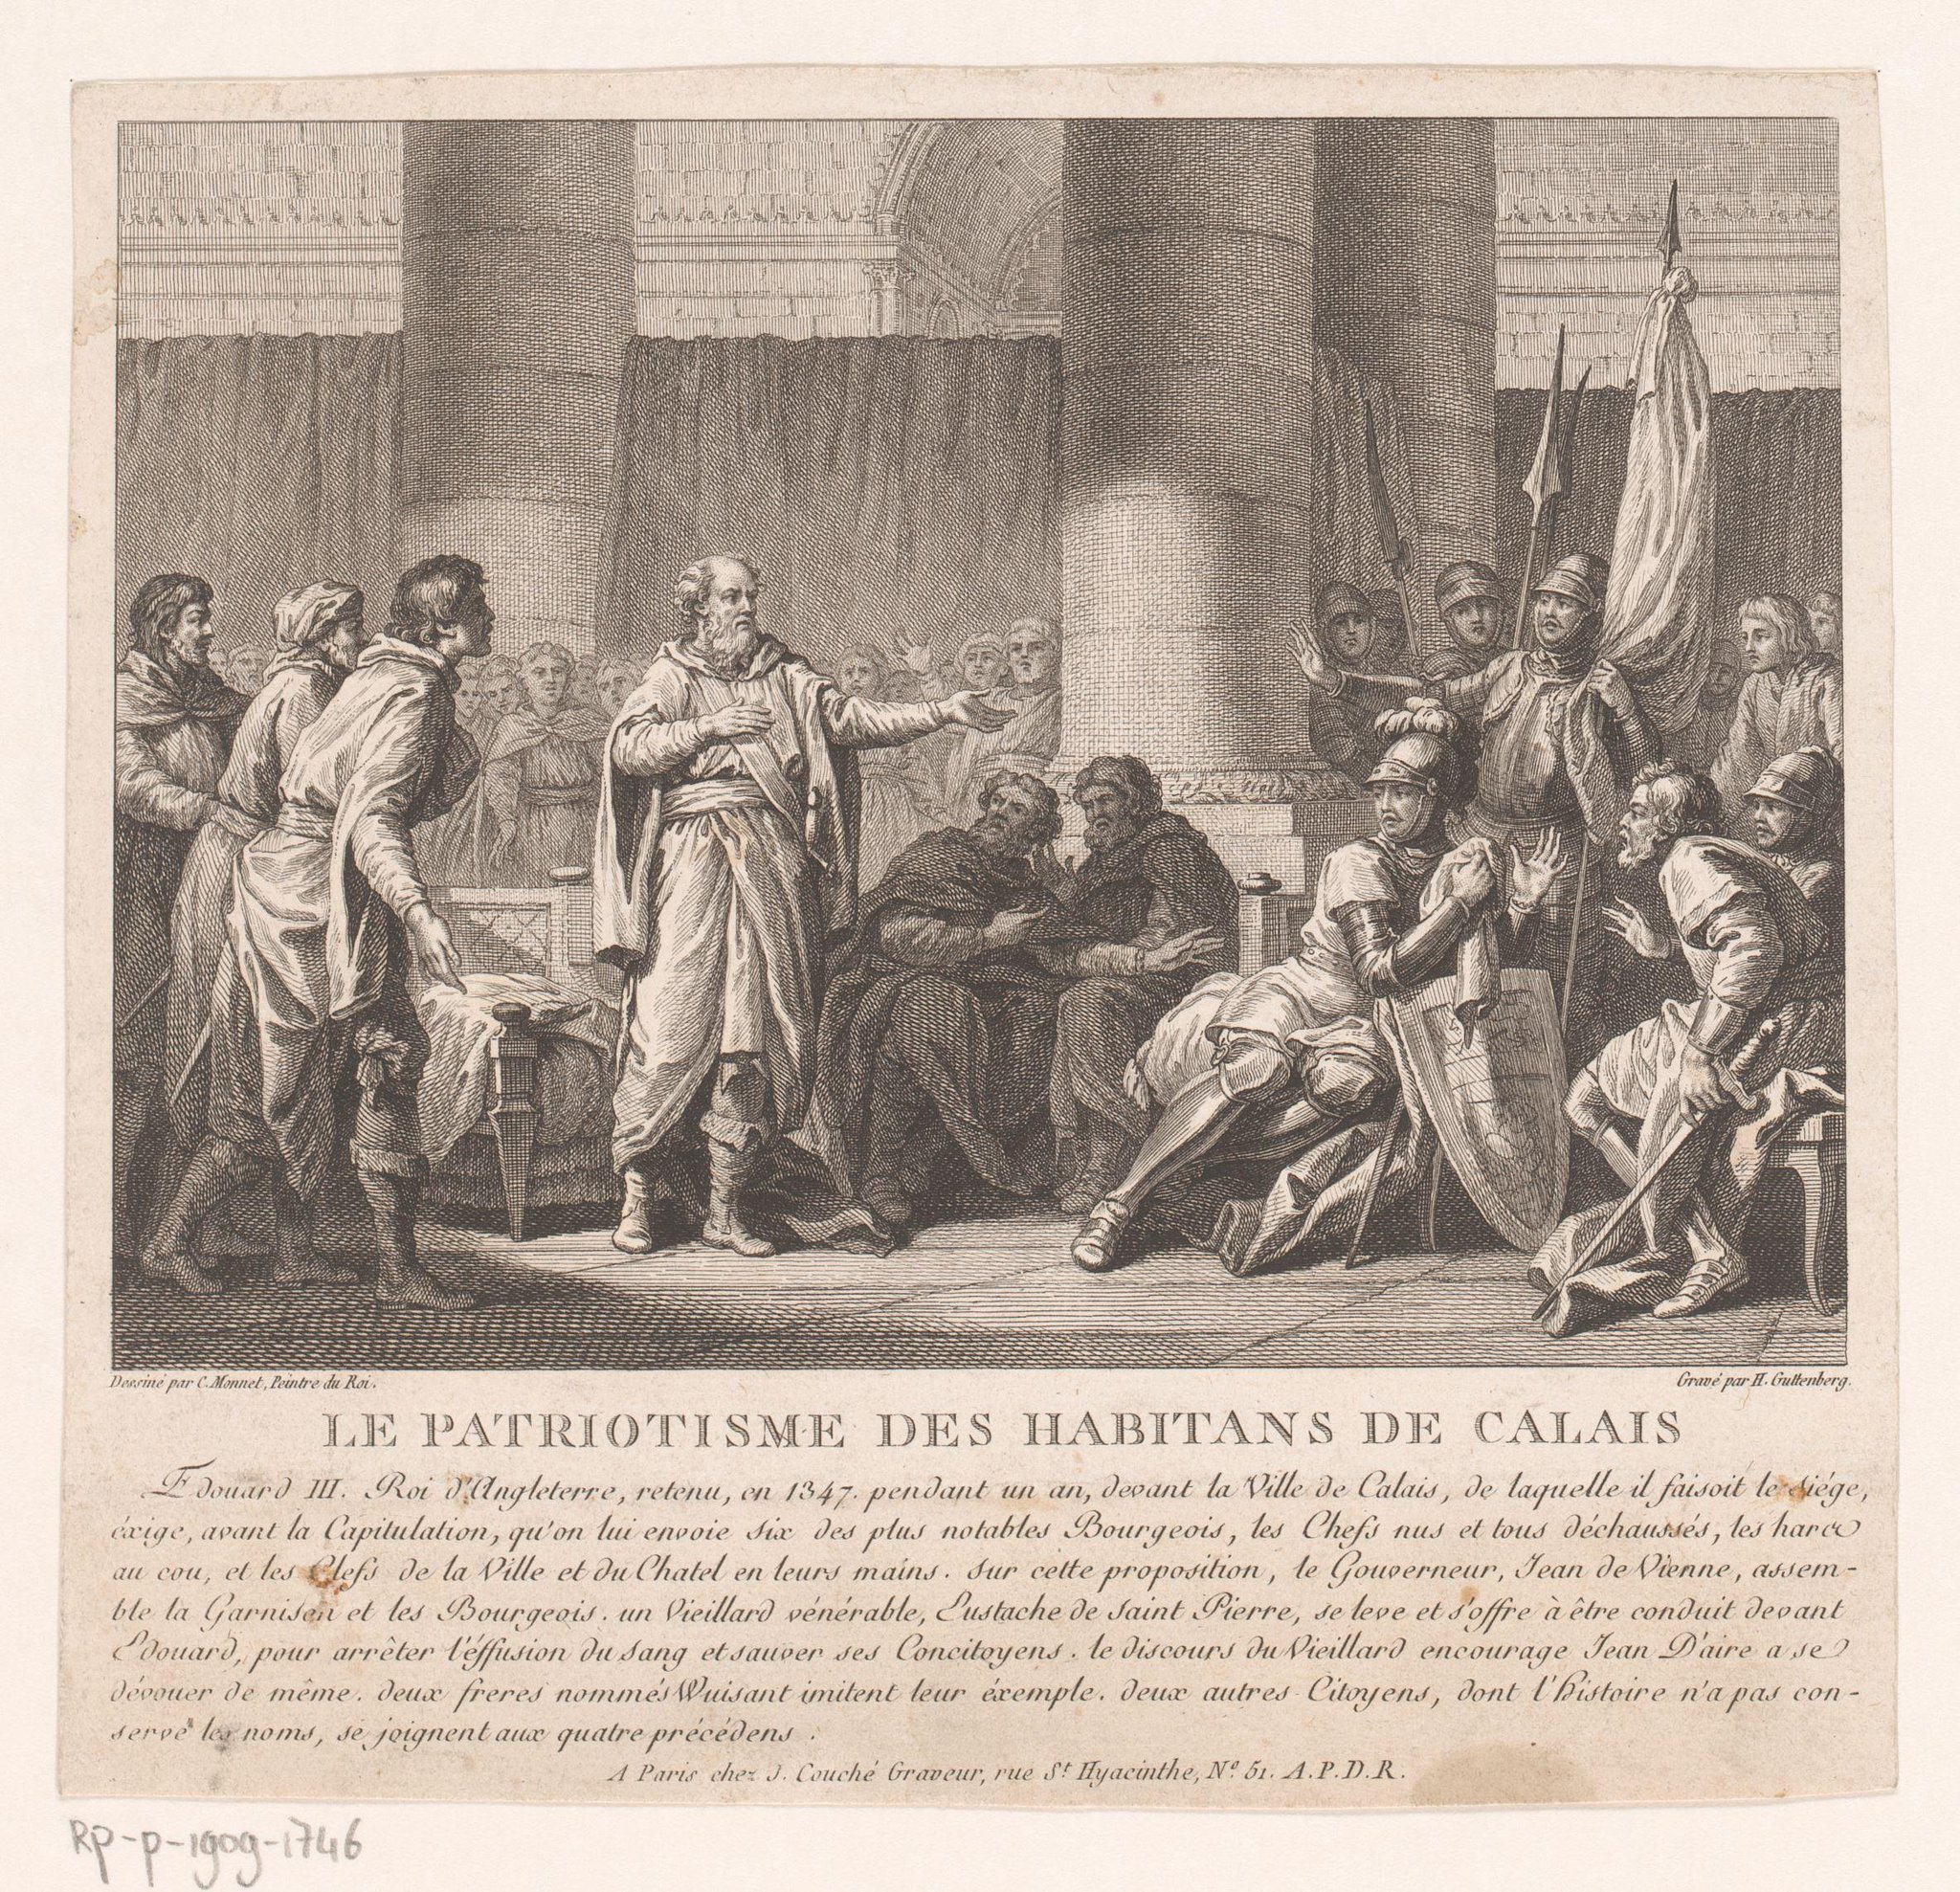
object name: print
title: Le patriotisme des habitans de Calais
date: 1759-1818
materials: paper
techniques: etching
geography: paris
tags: patriotism, history, siege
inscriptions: collector's mark: Lugt 2228